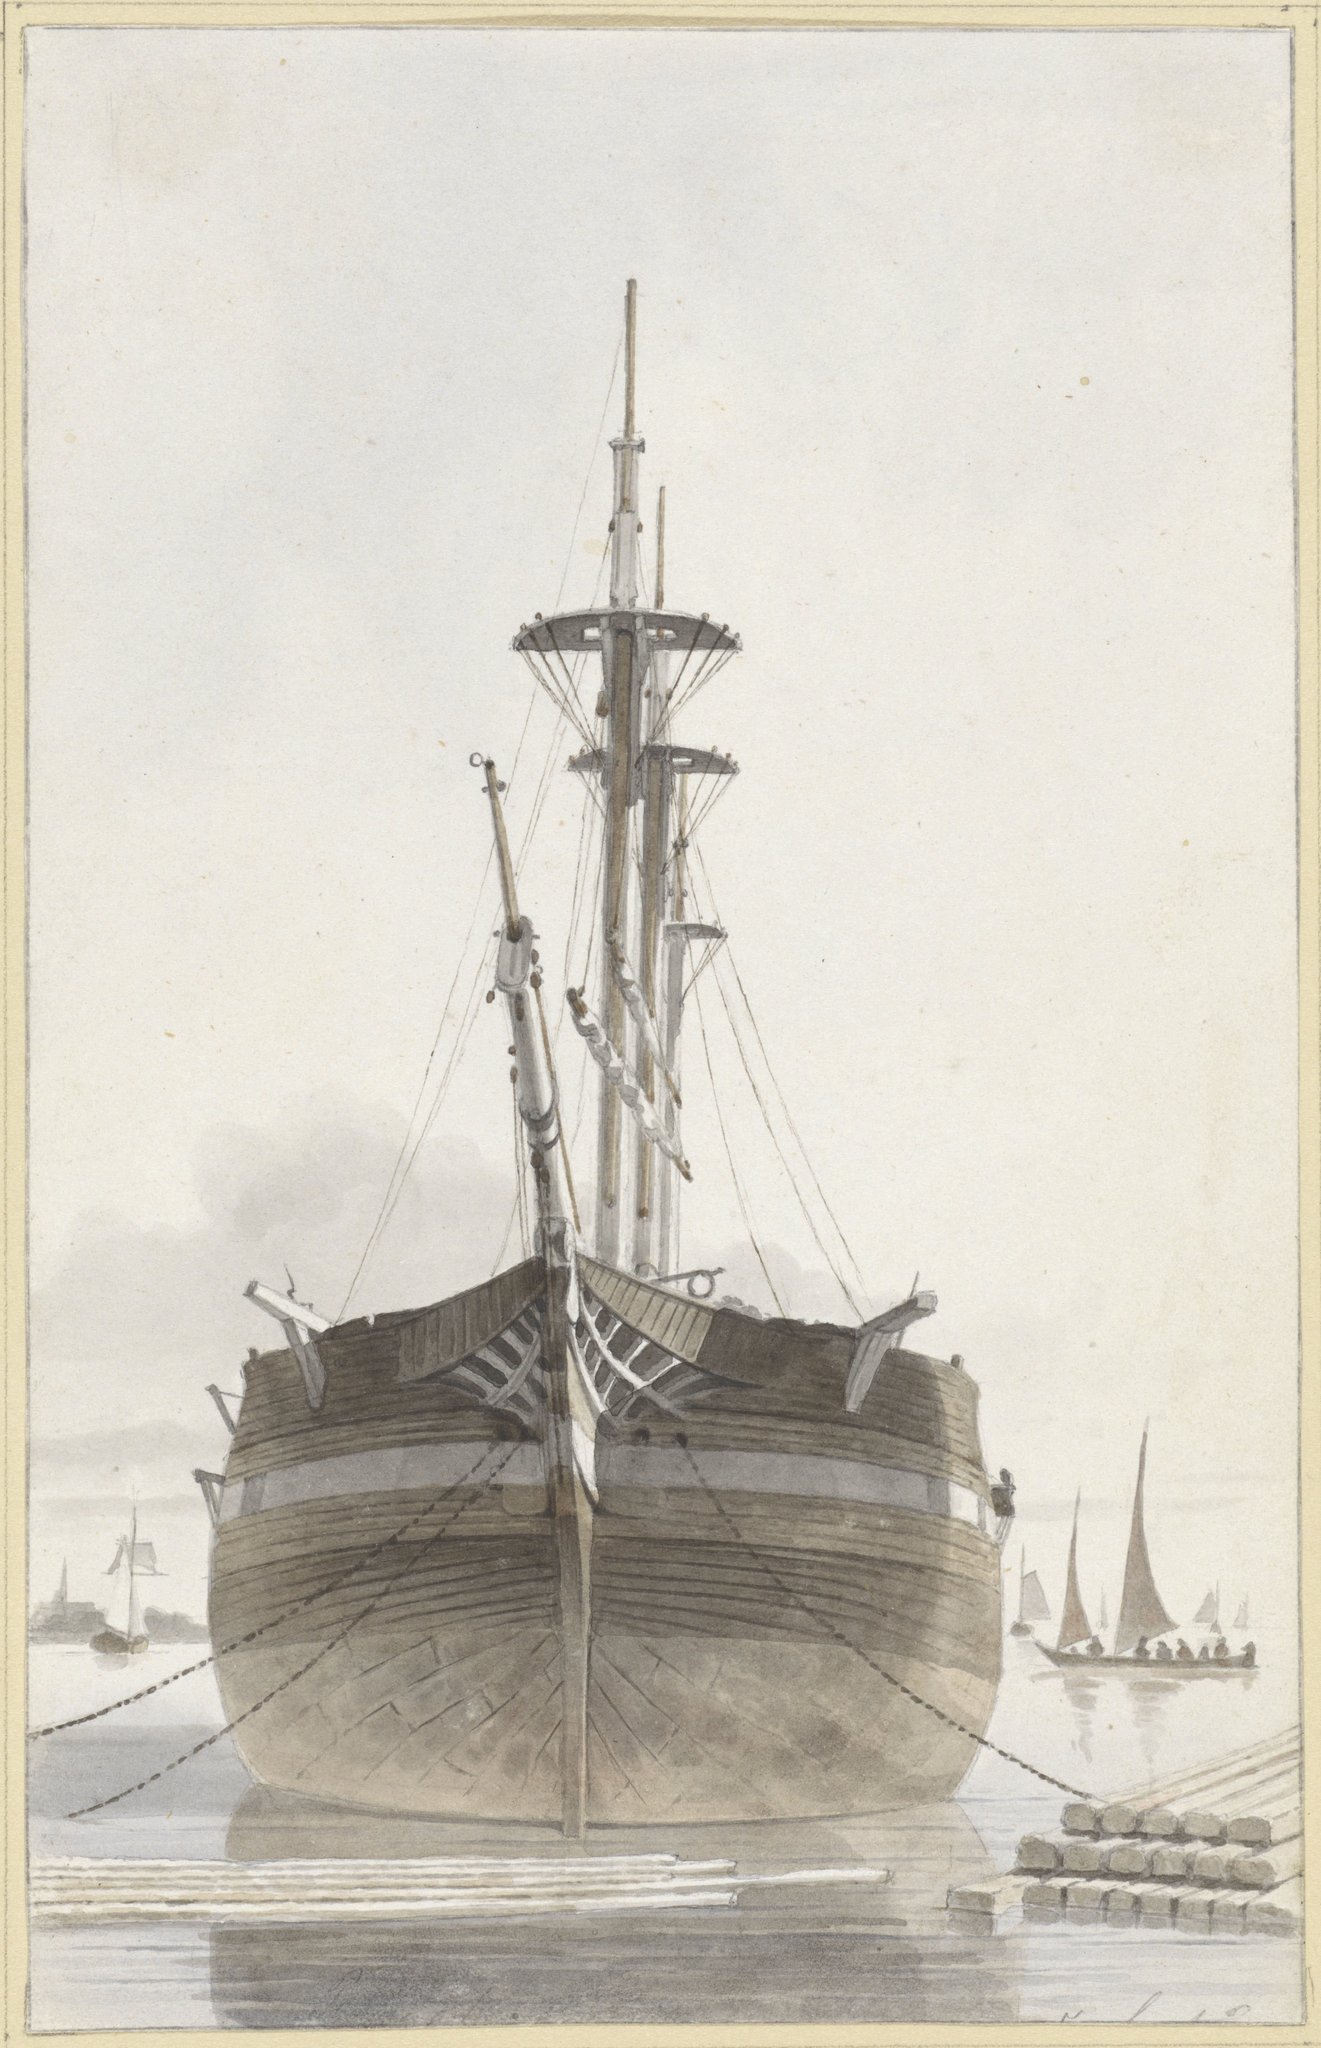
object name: watercolor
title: Zeilschip van voren gezien in een houthaven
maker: hendrik abraham klinkhamer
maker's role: draughtsman, painter, print maker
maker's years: 1810-1872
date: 1820-1872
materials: paper, pencil, watercolor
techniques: brush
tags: sailing-ship, sailing-boat